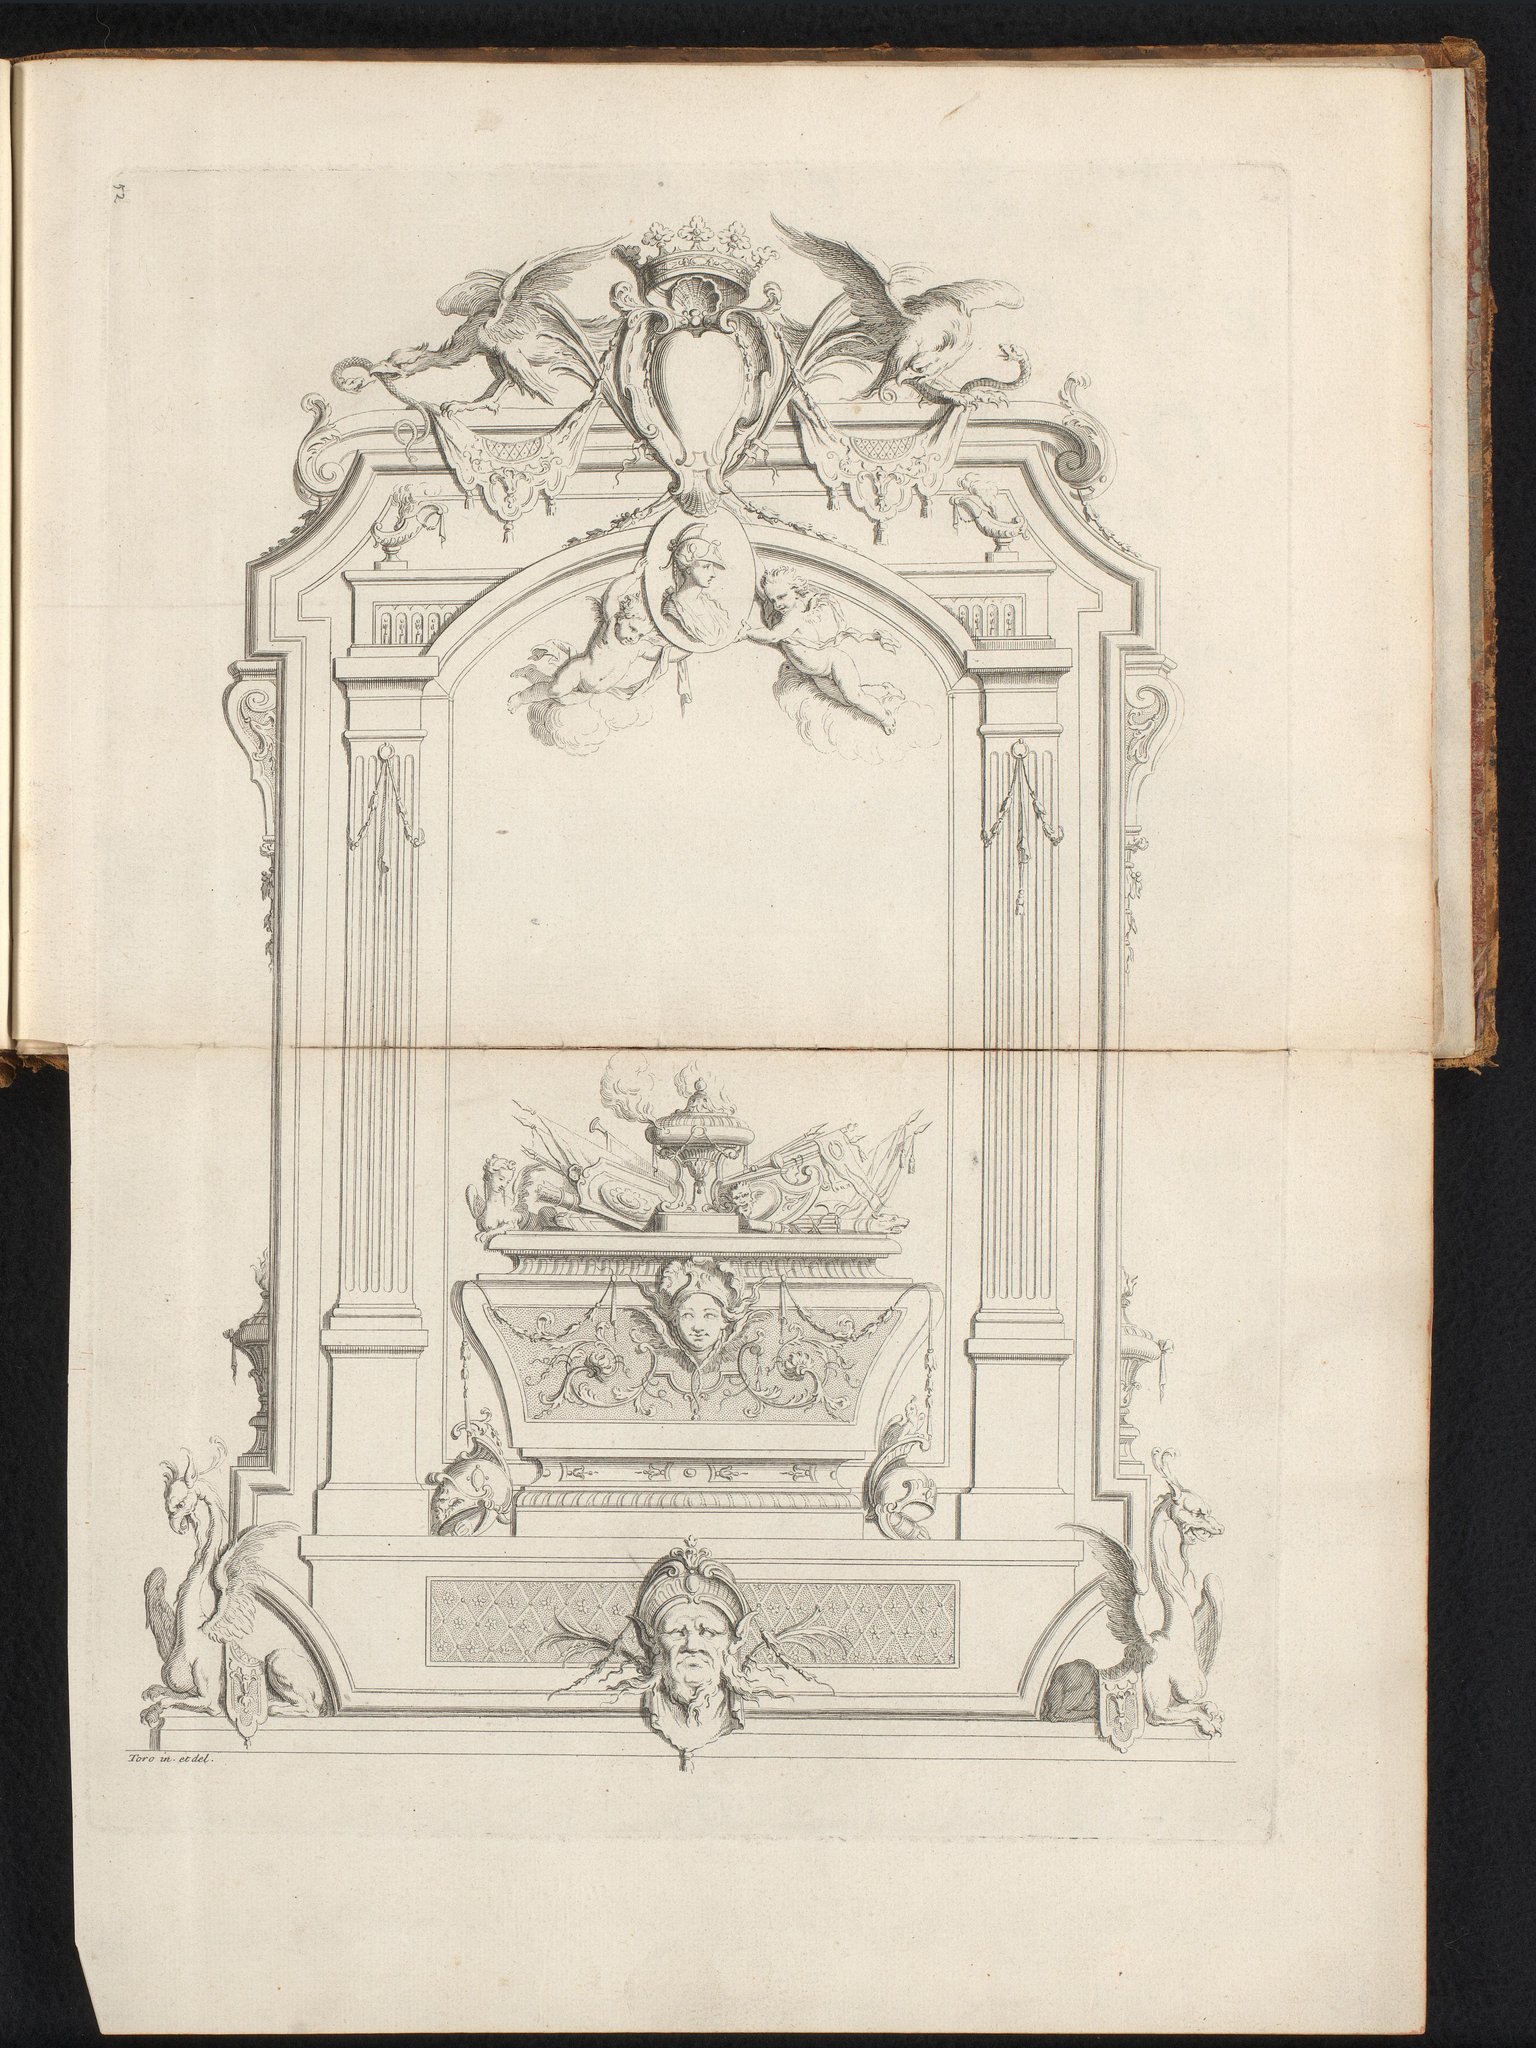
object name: album leaf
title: Ontwerpen voor tombes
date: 1682-1739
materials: paper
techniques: etching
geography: paris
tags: fabulous animals (sometimes wrongly called 'grotesques'); 'mostri' (ripa), 'tropaion', i.e. decorative ornament ~ weapons, monsters of mixed human and animal shape; 'mostri' (ripa), grave, tomb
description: Prent maakt deel uit van een serie van vijf prenten.